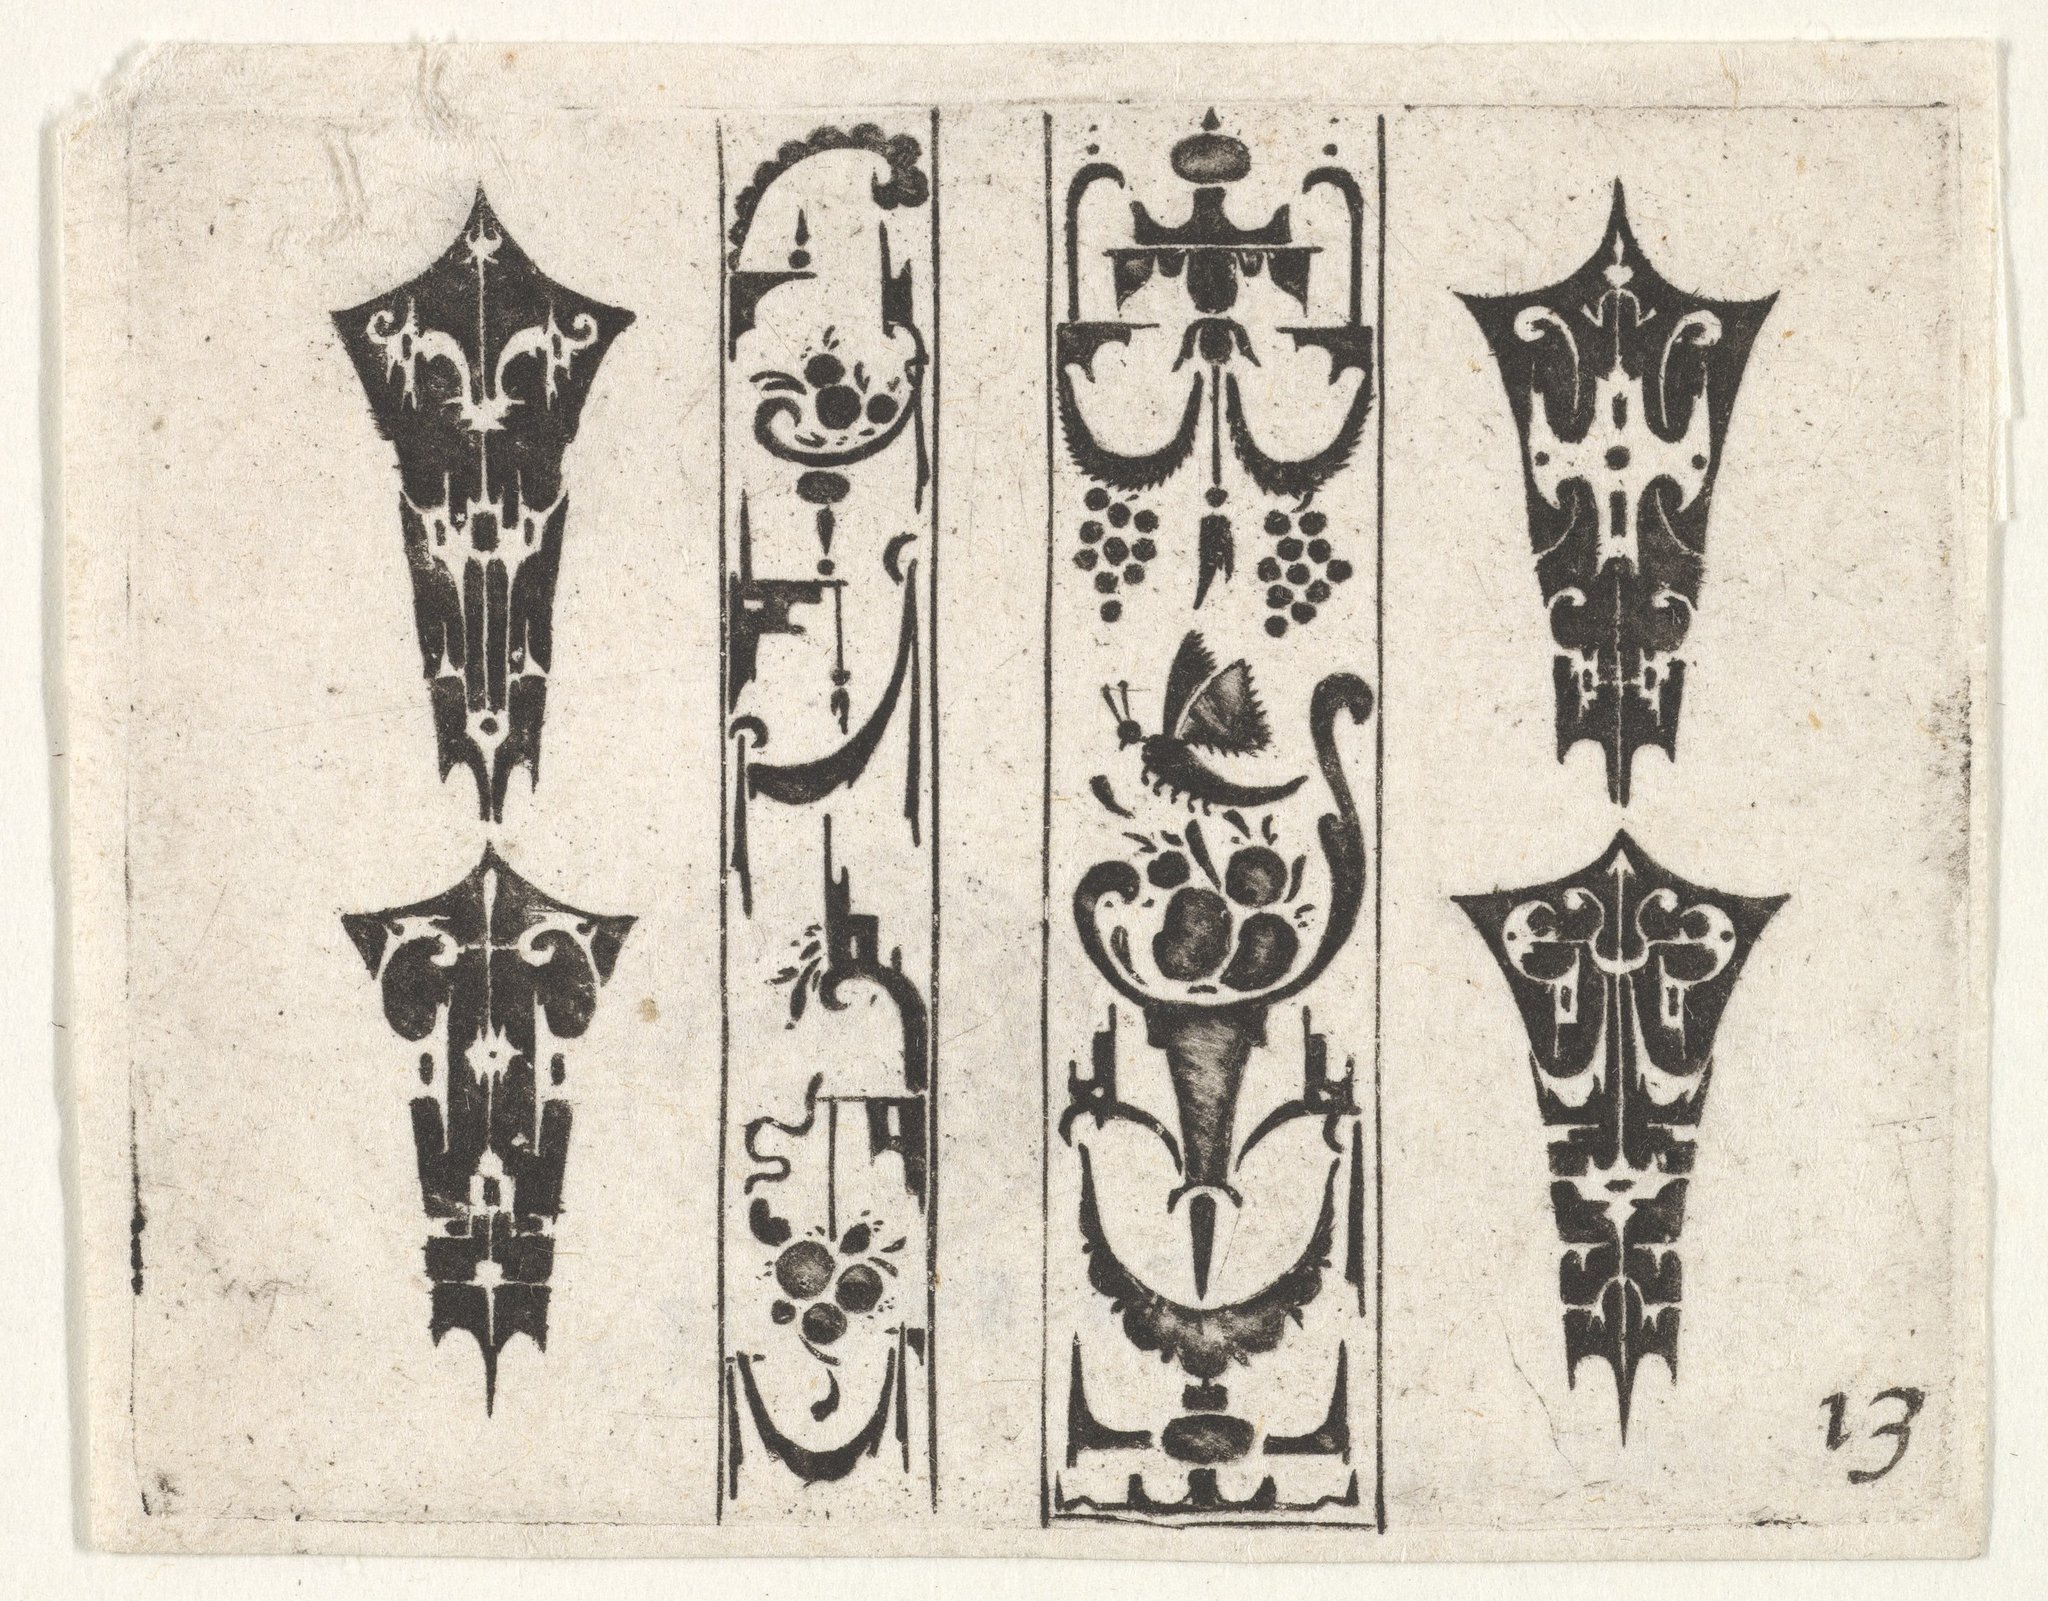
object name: print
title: Blackwork Print with Two Vertical Panels and Four Bezels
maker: claes jansz. visscher (ii)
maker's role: artist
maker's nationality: dutch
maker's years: 1586-1652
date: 1620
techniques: embroidery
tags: ornament